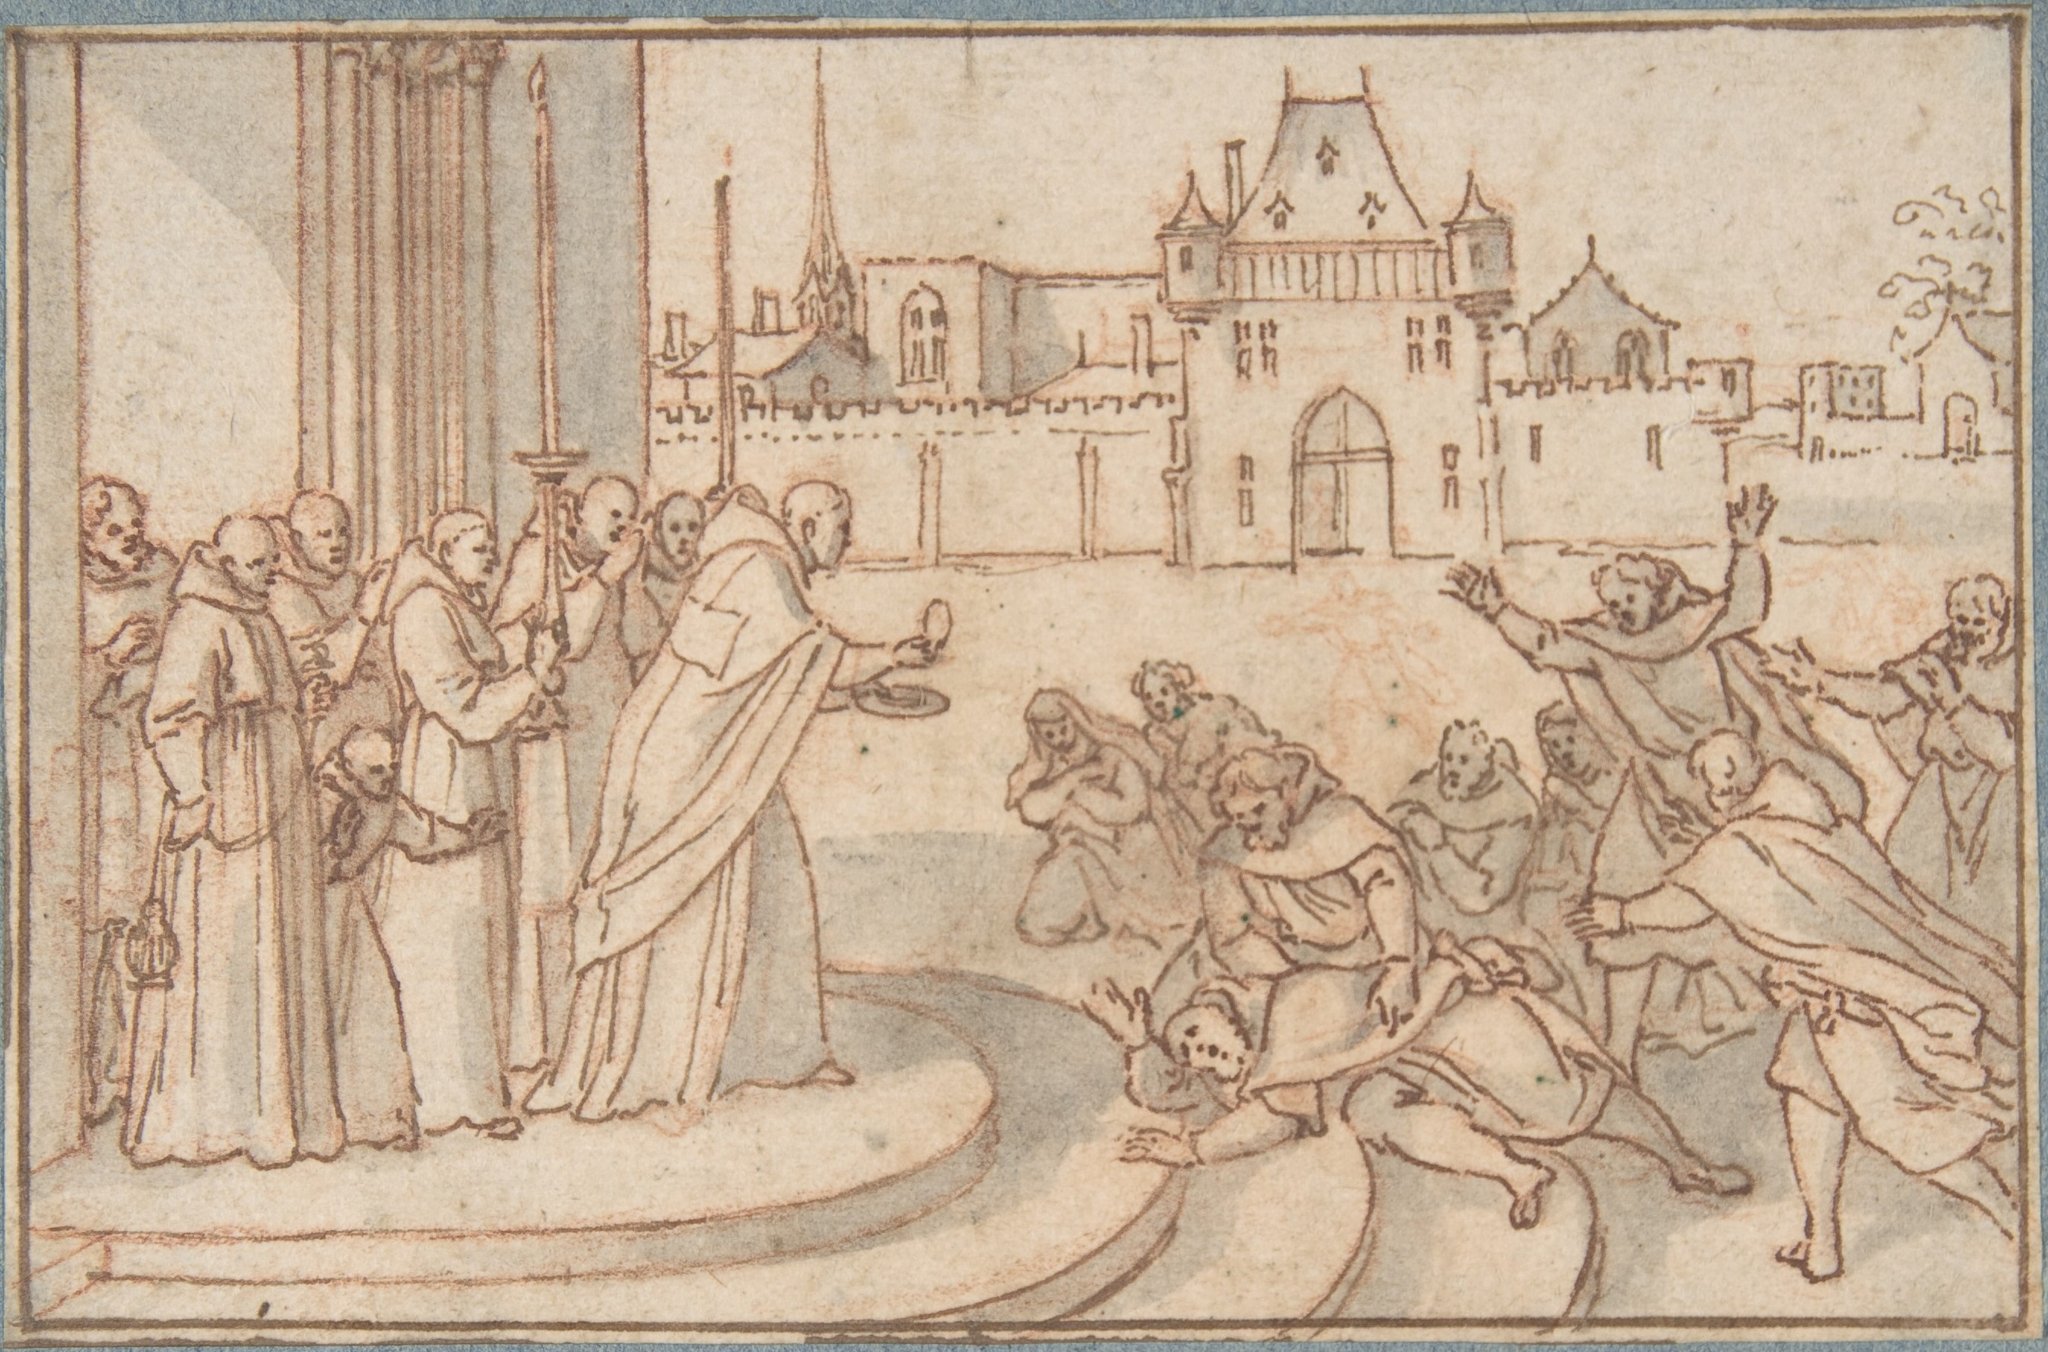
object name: drawing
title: Saint Bernard presenting the host to Guillaume X, duc de Guyenne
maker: sébastien leclerc (i)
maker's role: artist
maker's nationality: french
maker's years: 1637-1714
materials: chalk, ink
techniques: brush, pen, wash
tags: buildings,men,saints